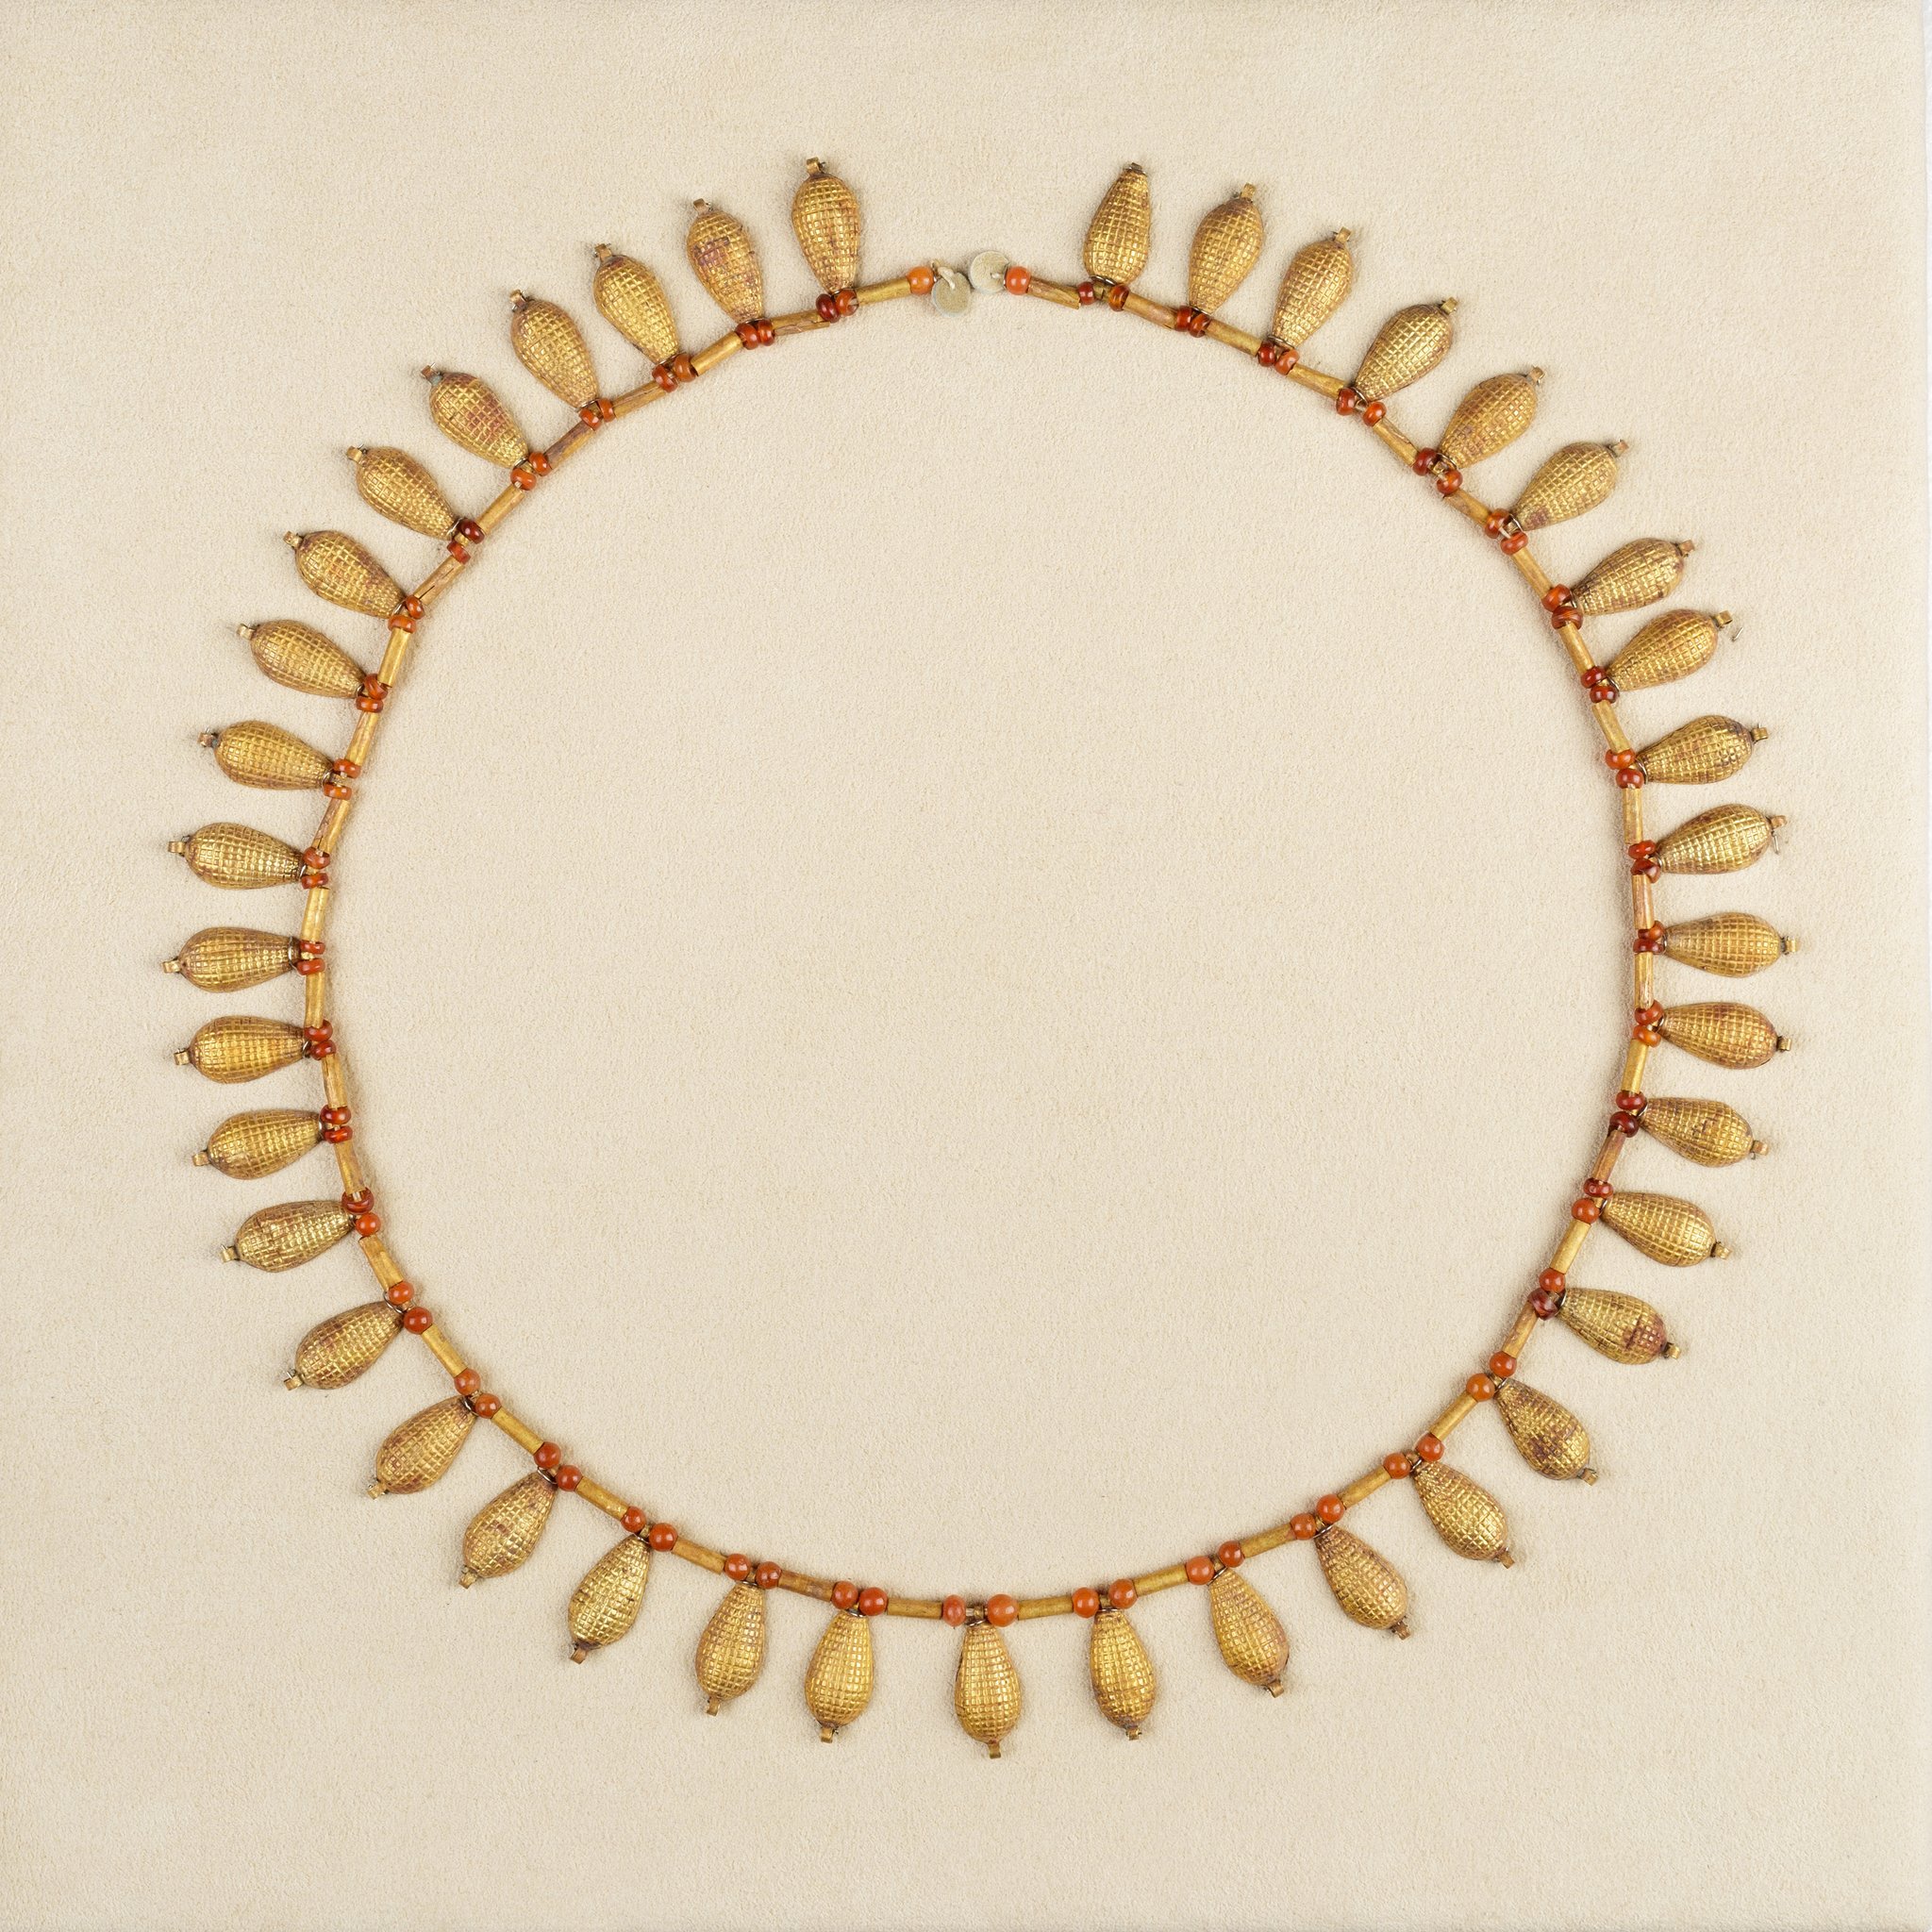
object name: necklace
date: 1550-1295 BCE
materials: gemstone, gold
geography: egypt